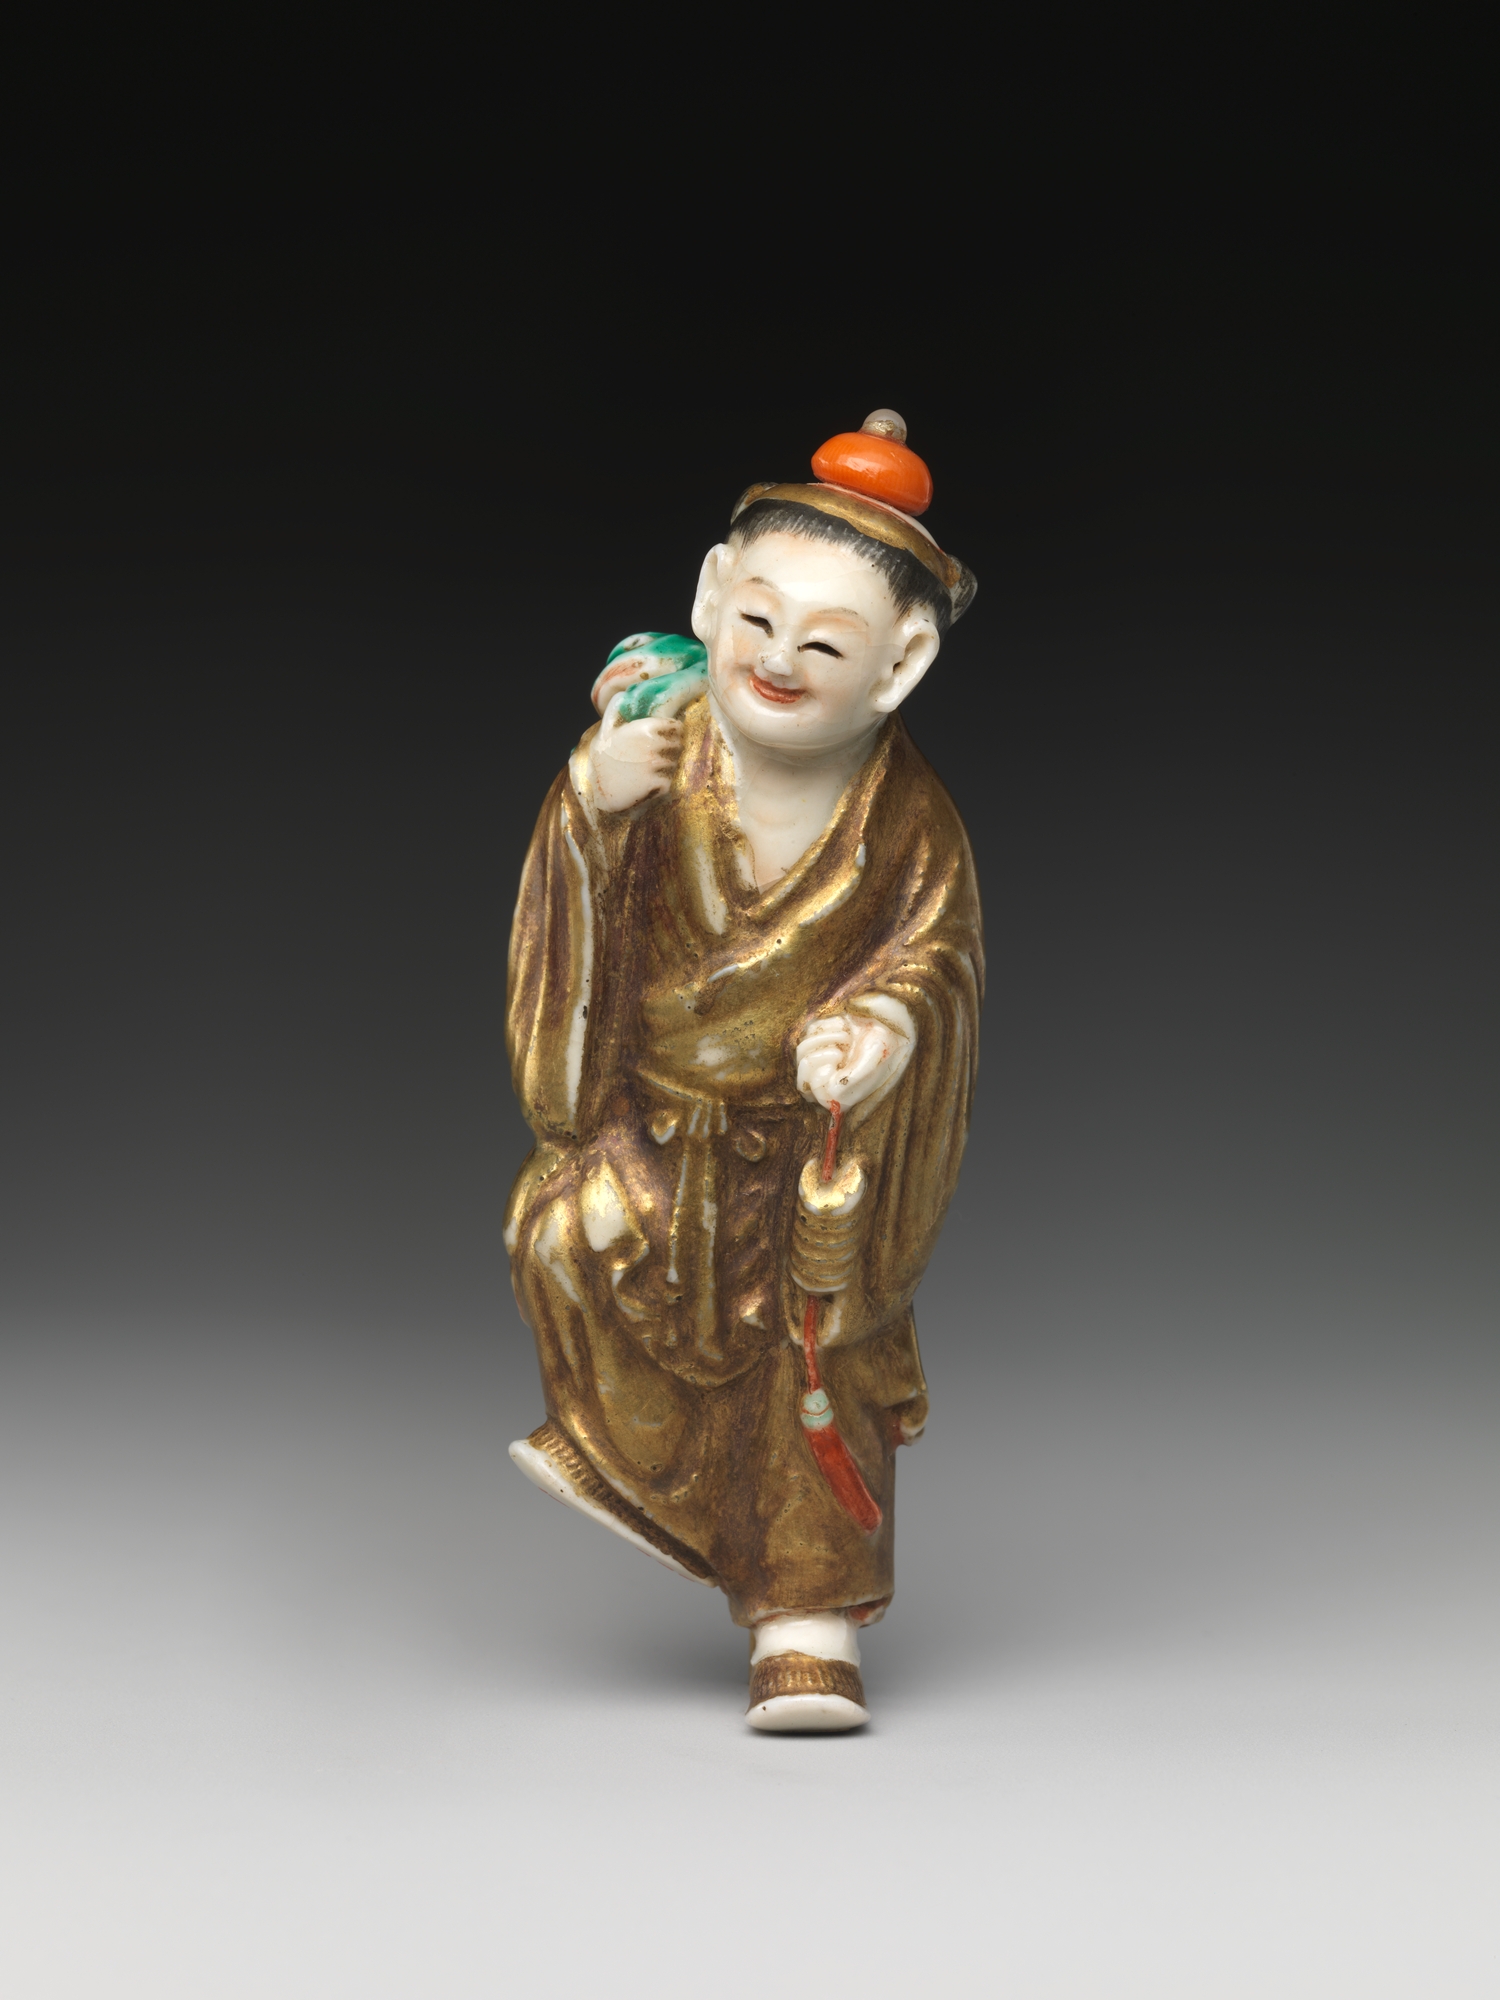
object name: snuff bottle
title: Snuff Bottle Depicting the Immortal Liu Hai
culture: chinese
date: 1767-1833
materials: coral, enamel, porcelain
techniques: overglaze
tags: men